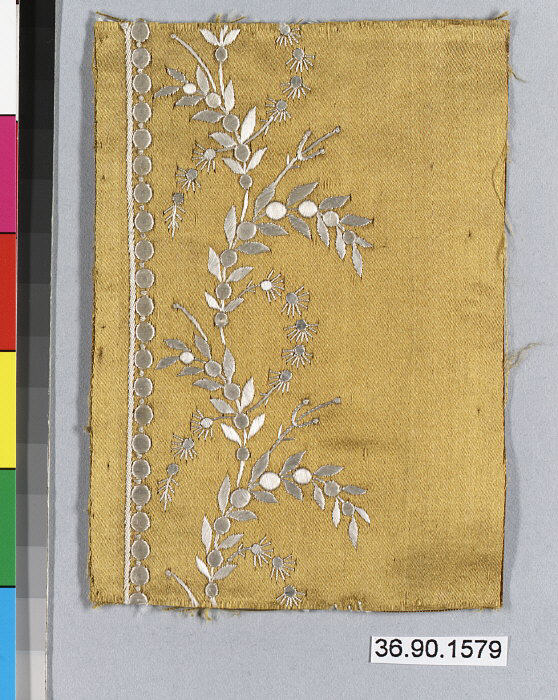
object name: sample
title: Embroidery sample for a man’s suit or waistcoat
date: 1785-1815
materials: silk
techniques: embroidery